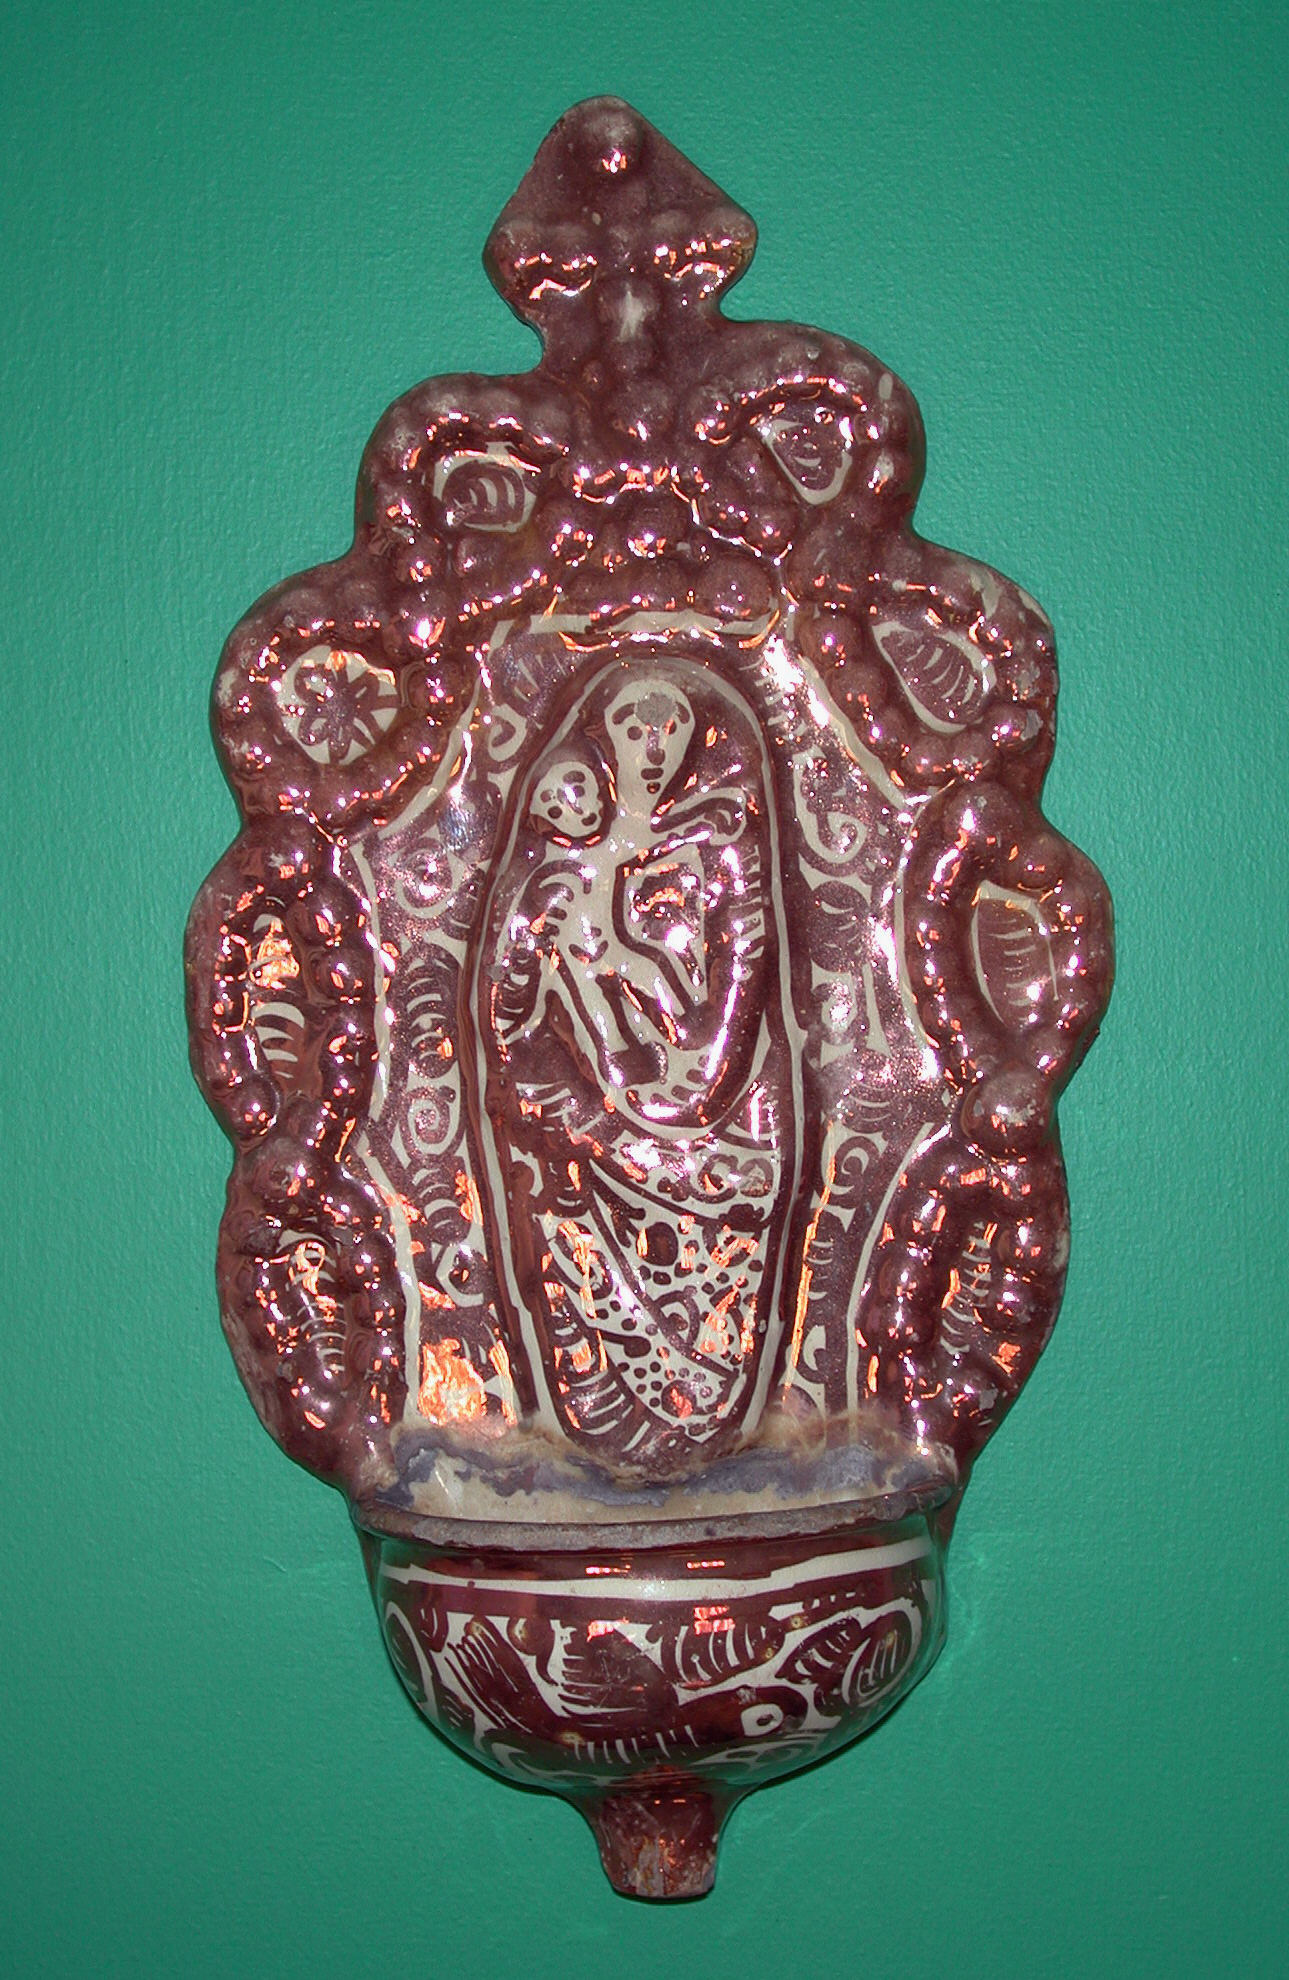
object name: bénitier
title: Pair of bénitiers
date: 1701-1800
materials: earthenware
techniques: luster painting, glazing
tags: madonna and child